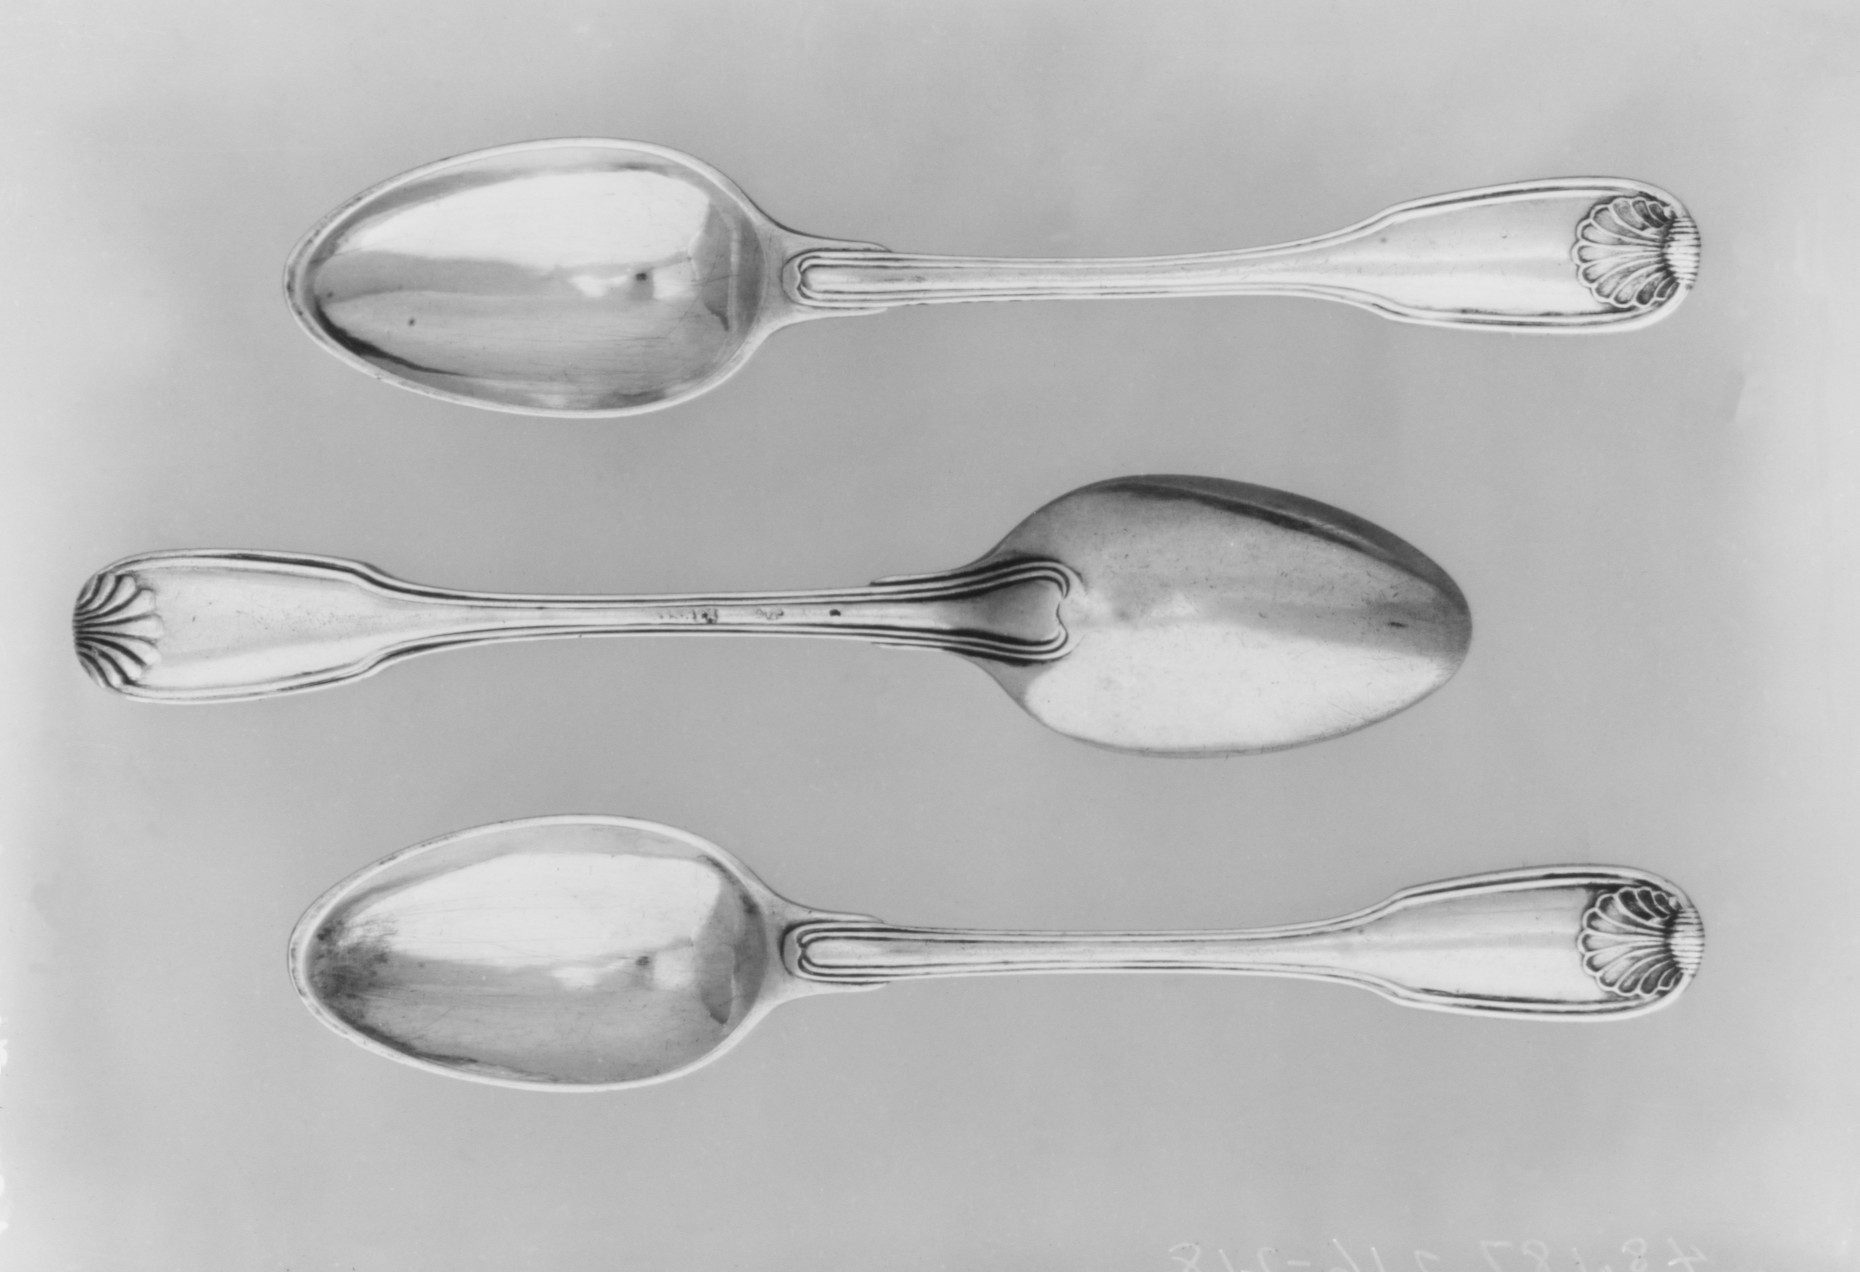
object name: spoon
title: Set of three spoons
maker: jean-jacques kirstein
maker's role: maker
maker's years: 1760-1798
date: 1760-1789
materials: silver